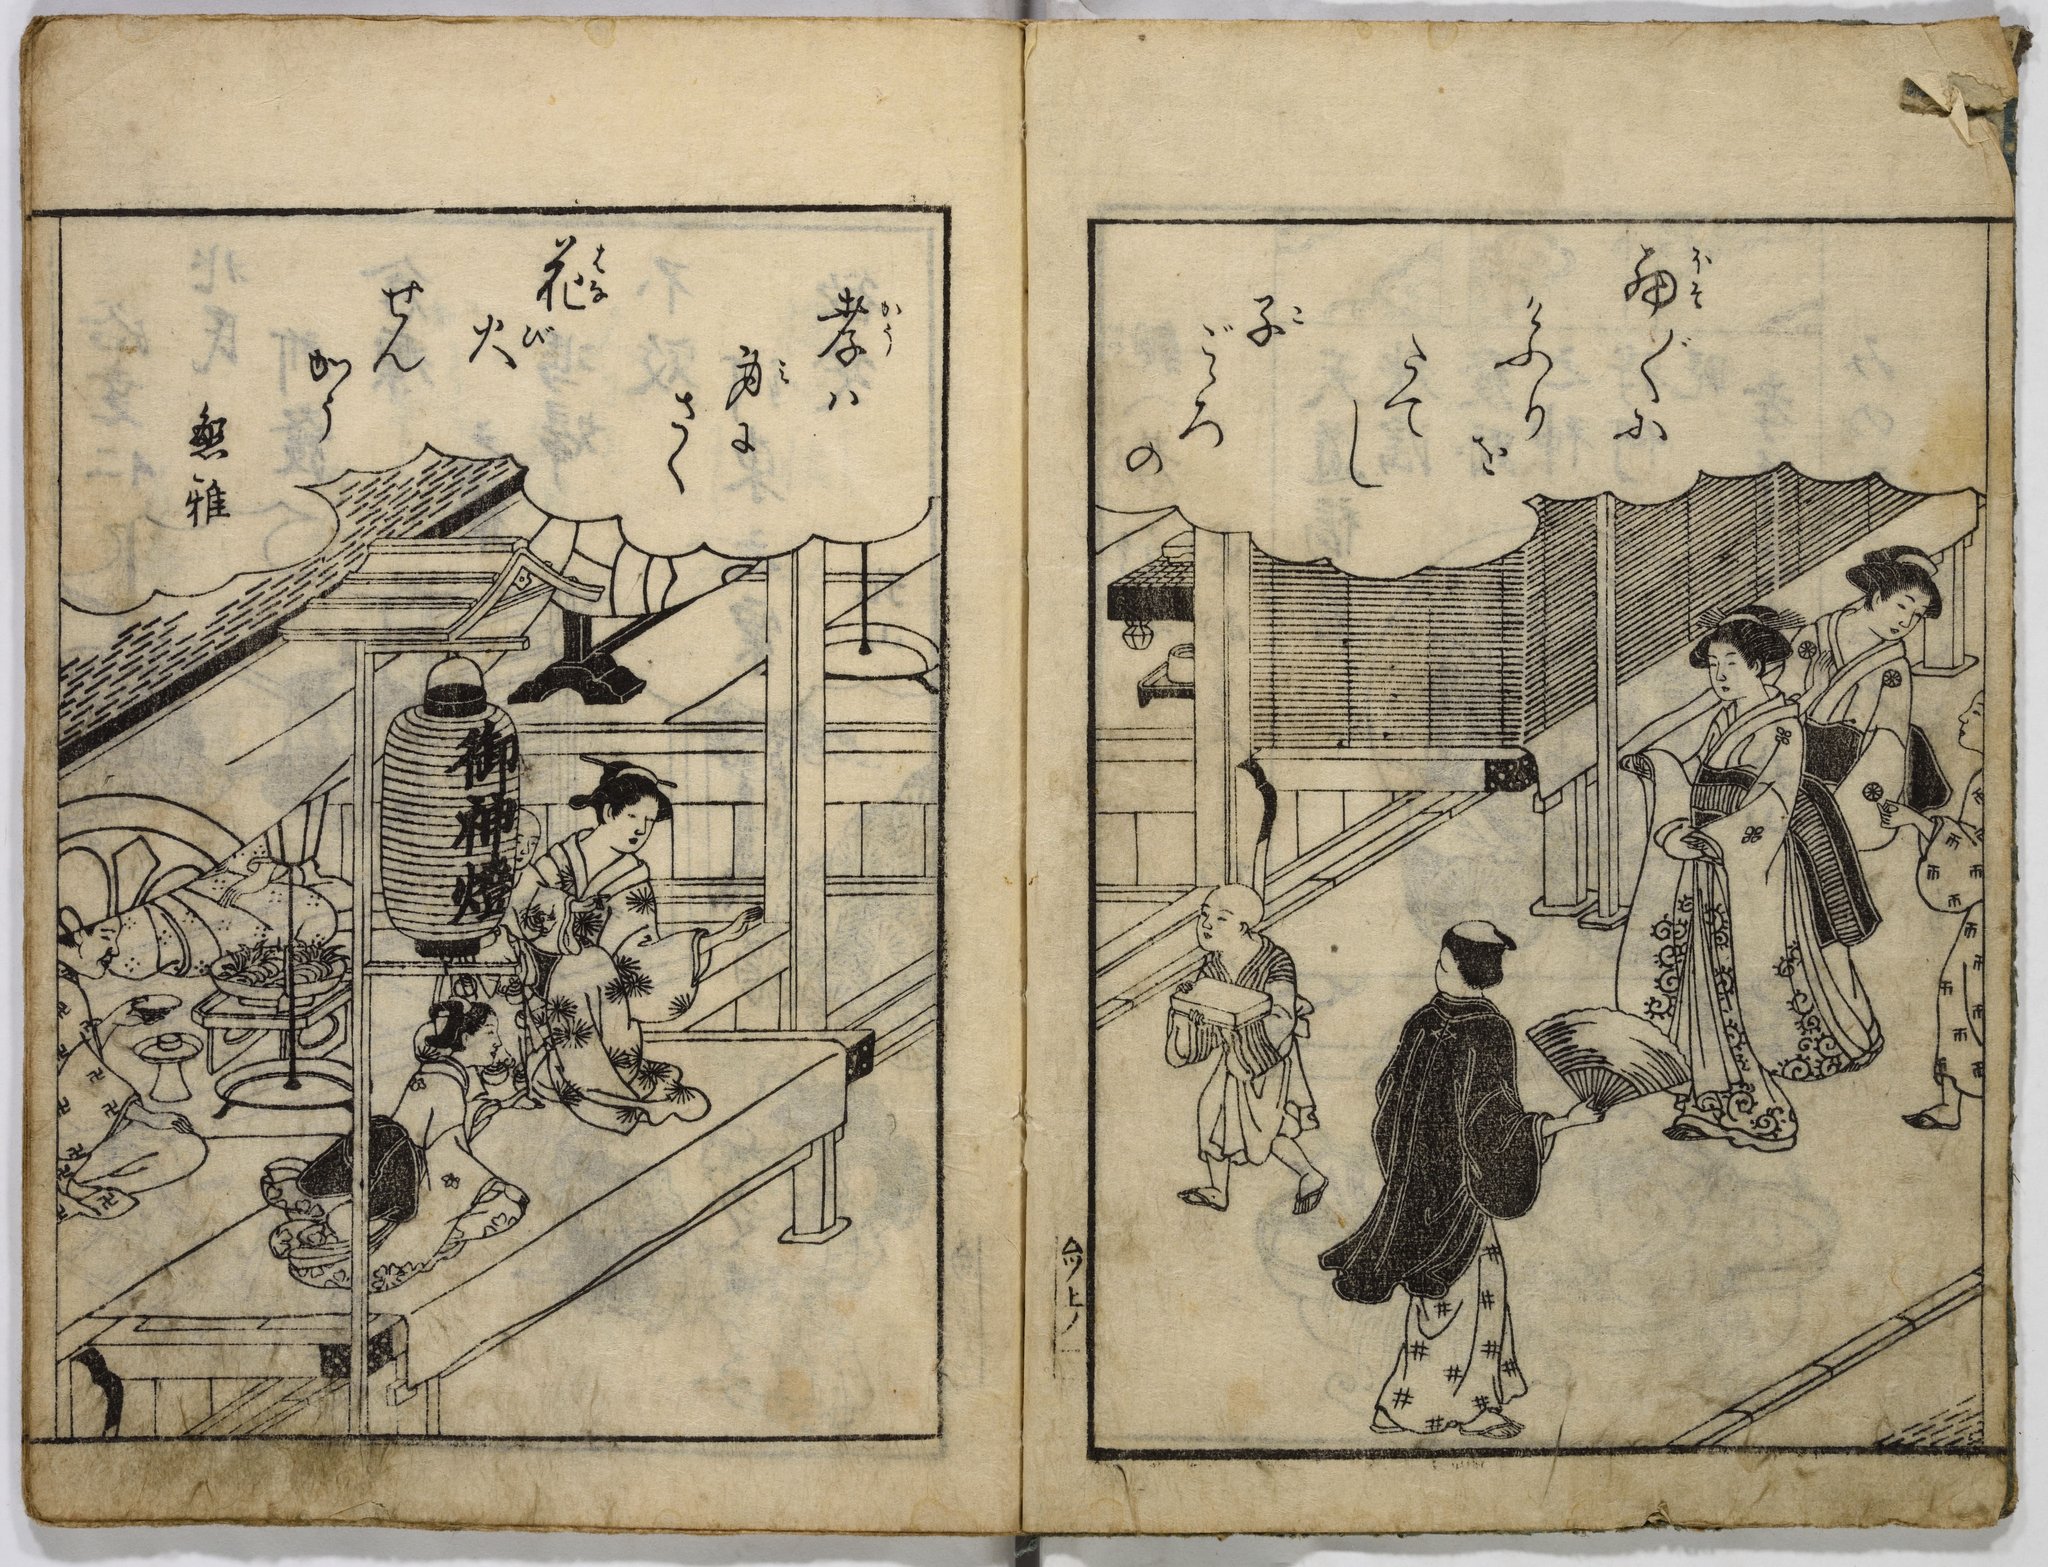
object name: illustrated book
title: Instructions on Ethics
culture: japanese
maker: unidentified artist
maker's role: artist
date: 1615-1868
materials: ink, paper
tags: fans,boys,women